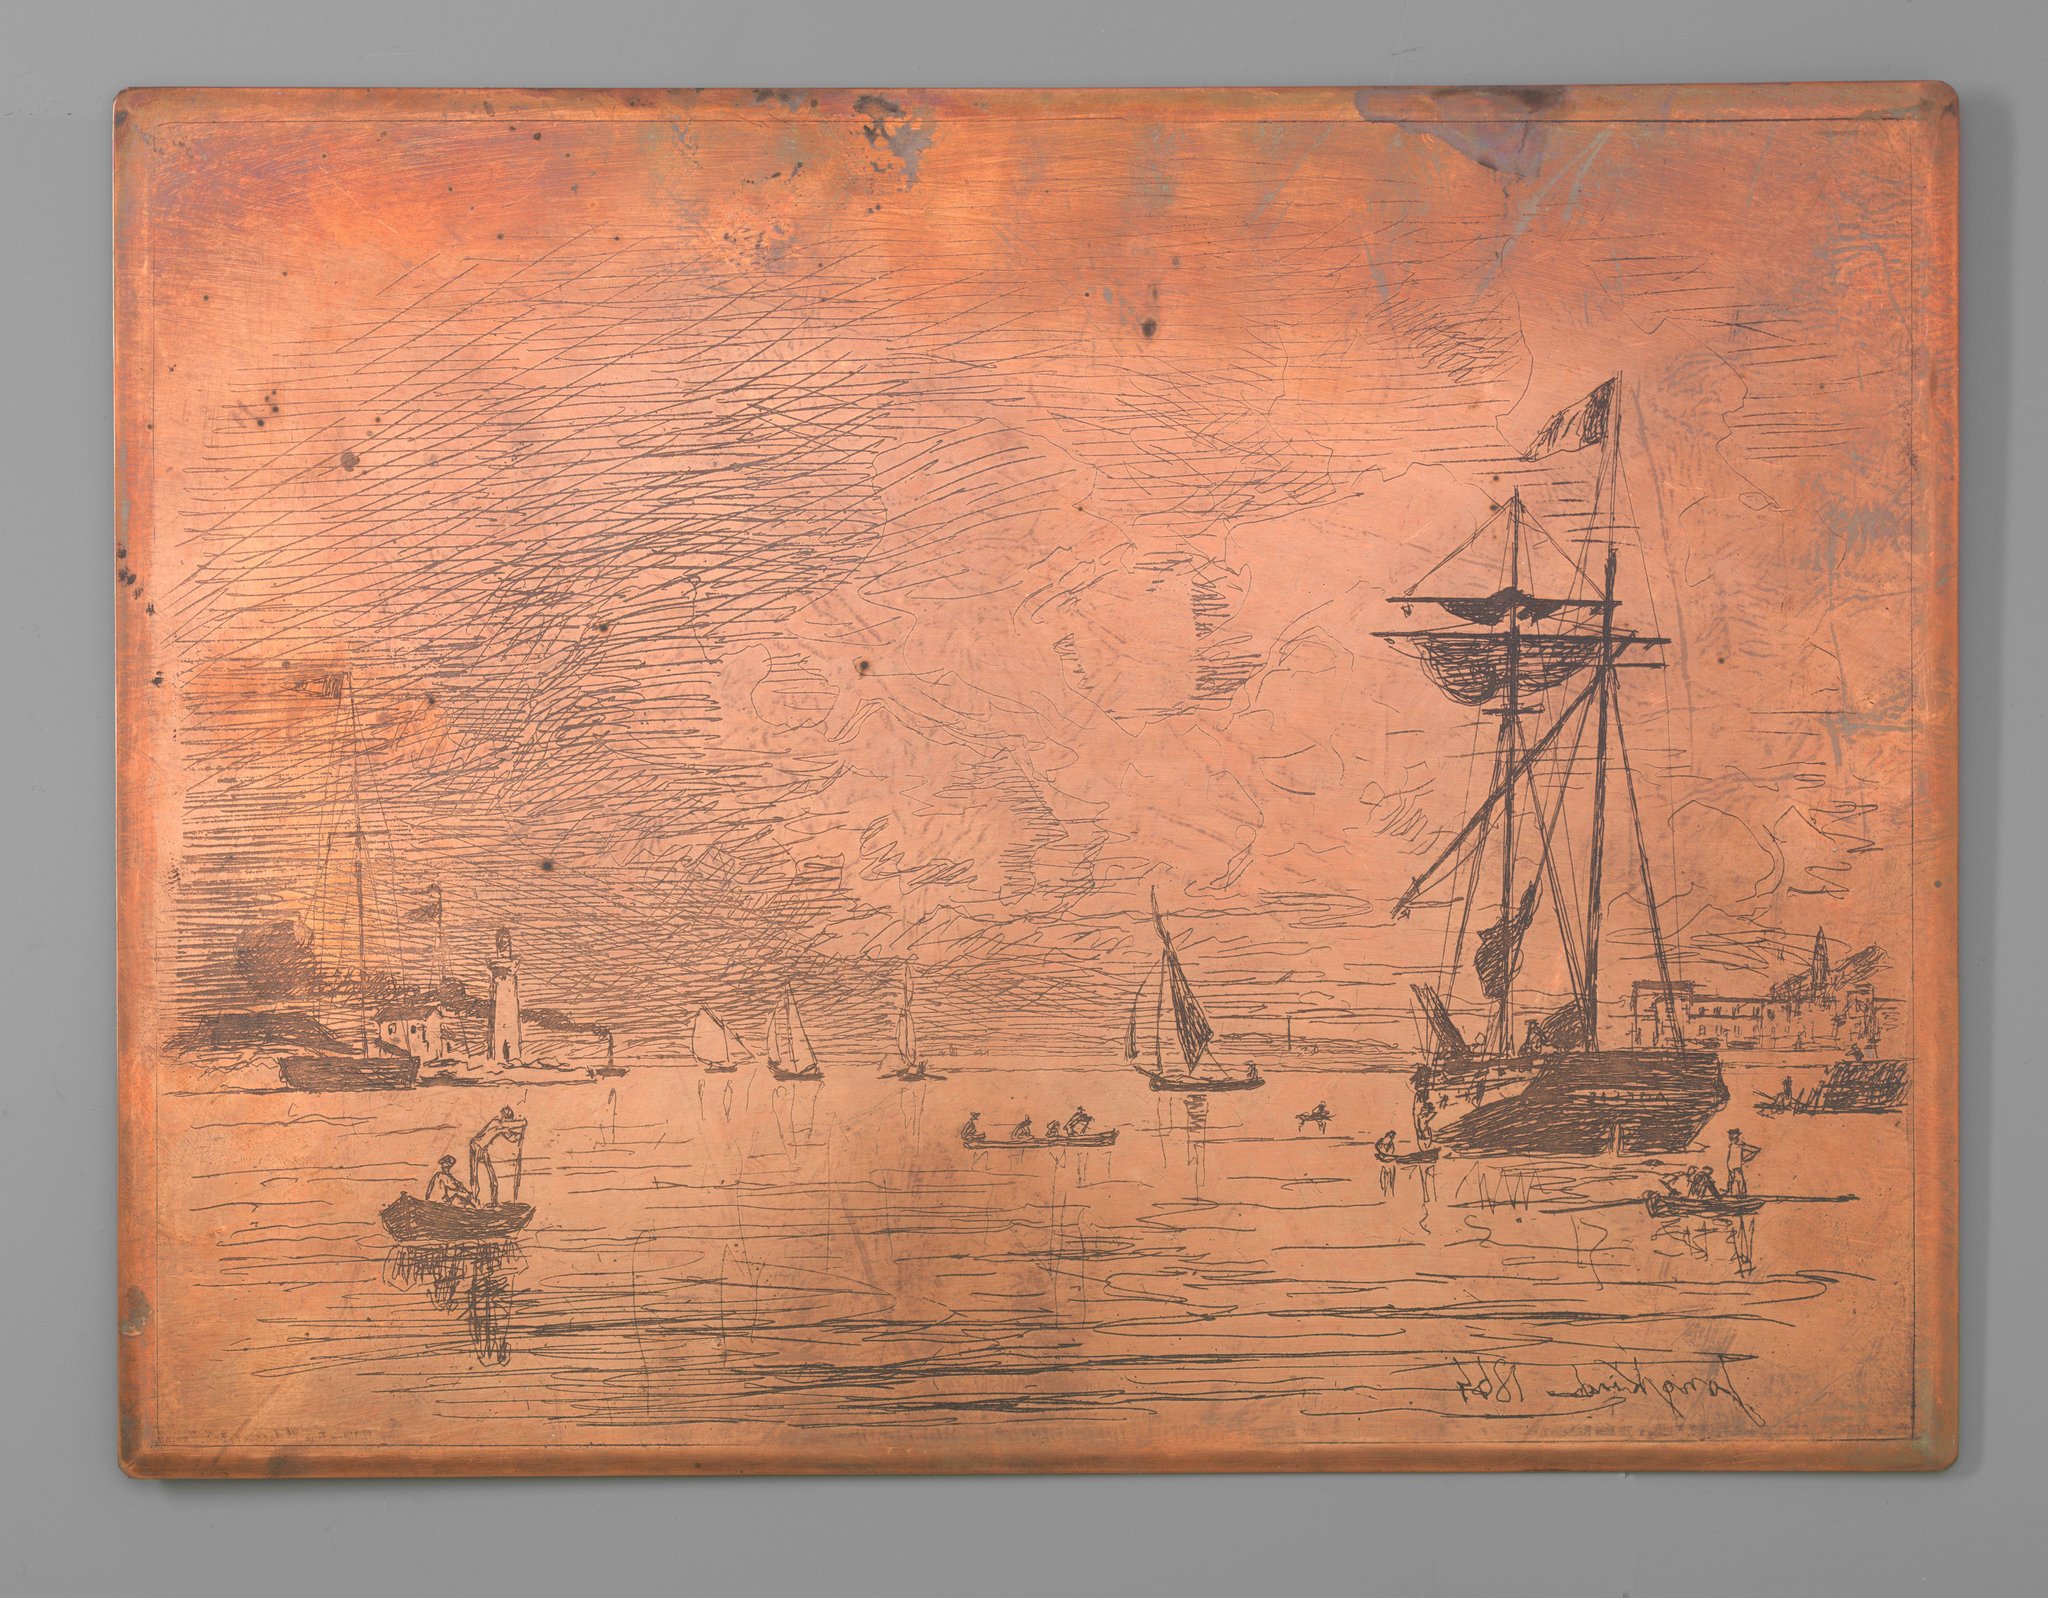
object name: copper plate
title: Haven van Honfleur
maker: johan barthold jongkind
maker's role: draughtsman, painter, print maker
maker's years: 1819-1891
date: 1864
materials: copper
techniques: etching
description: Op de achterzijde van de plaat bevindt zich een voorstelling met onder andere een ruiter, een lopende figuur en een hond (niet door Jongkind).